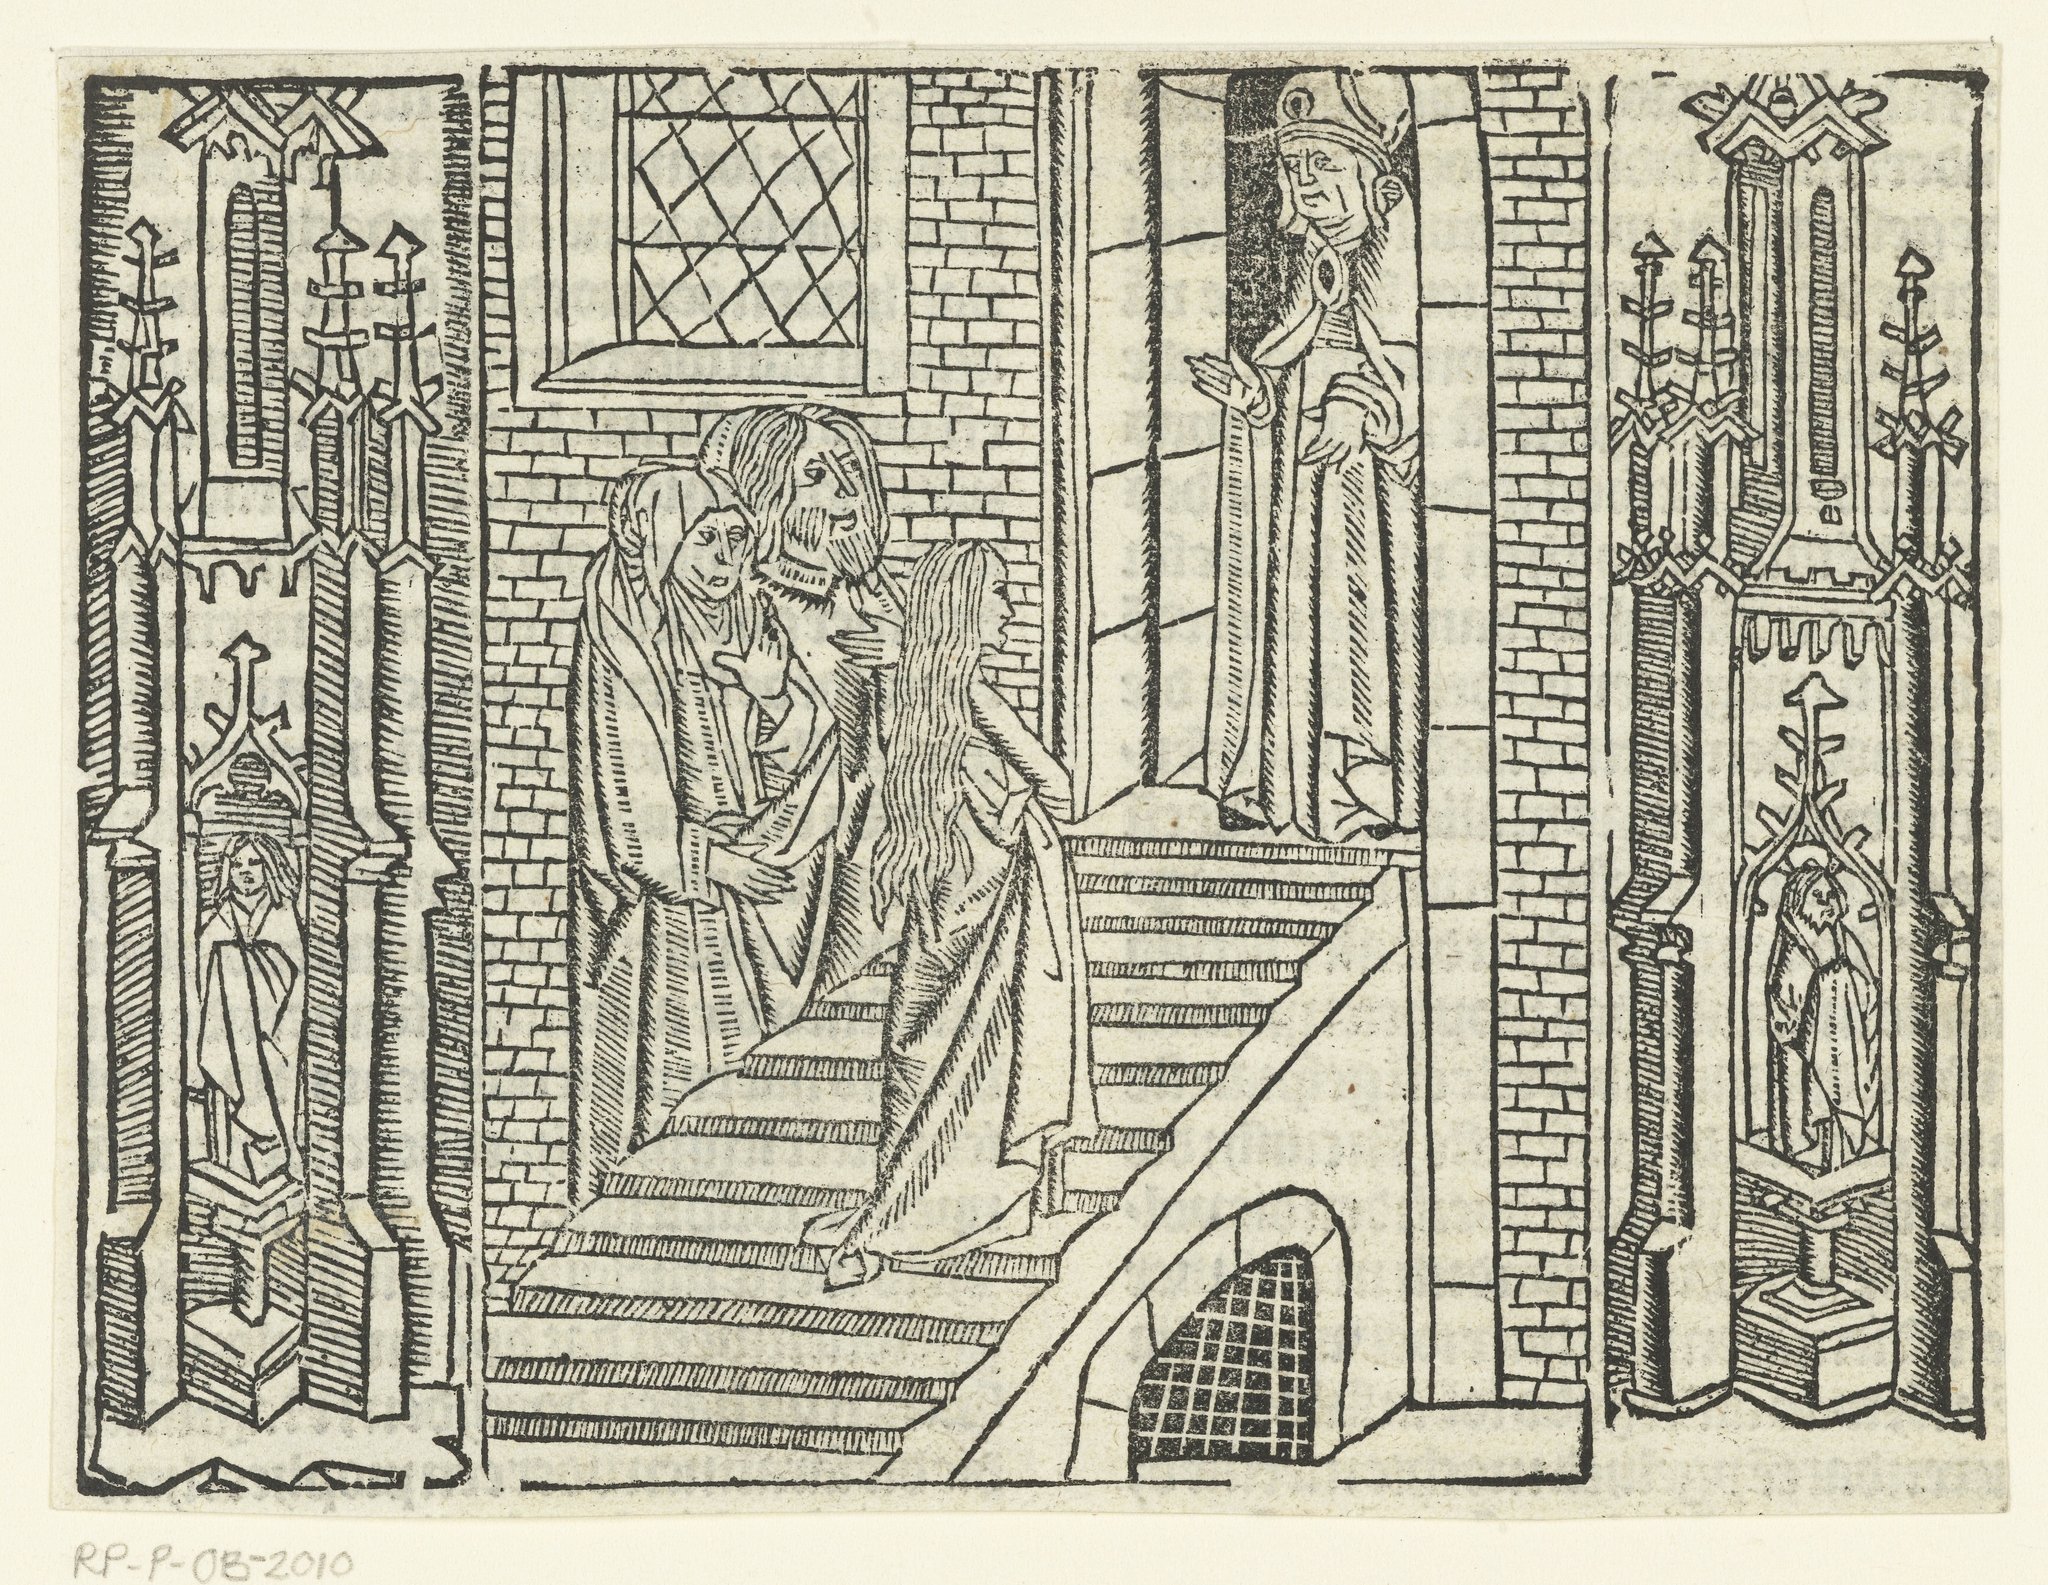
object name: book illustration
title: De presentatie van Maria in de tempel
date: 1480-1500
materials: paper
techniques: woodcut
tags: dedication (or presentation) of mary in the temple: she ascends the steps and is received by the high priest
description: Eén blad van 113 uit Ludolphus de Saxonia, "Dit es dleué ons liefs heeren ihesu christi". Anonieme Nederlandse vertaling. Uitgegeven door Henrick Eckert van Homberch te Antwerpen in 1503. Botke, K. Deze 113 houtsneden, die meestal reeds in vroege Nederlandse boeken gebruikt zijn, worden toegeschreven aan de tweede Meester van Delft, de Meester van de Delbecq-Schreiber-passie en de Meester van de Virgo inter Virgines. In Conway (1884) en in "De gulden passer"(1951) zijn ook eerdere versies opgenomen. Botke, K.